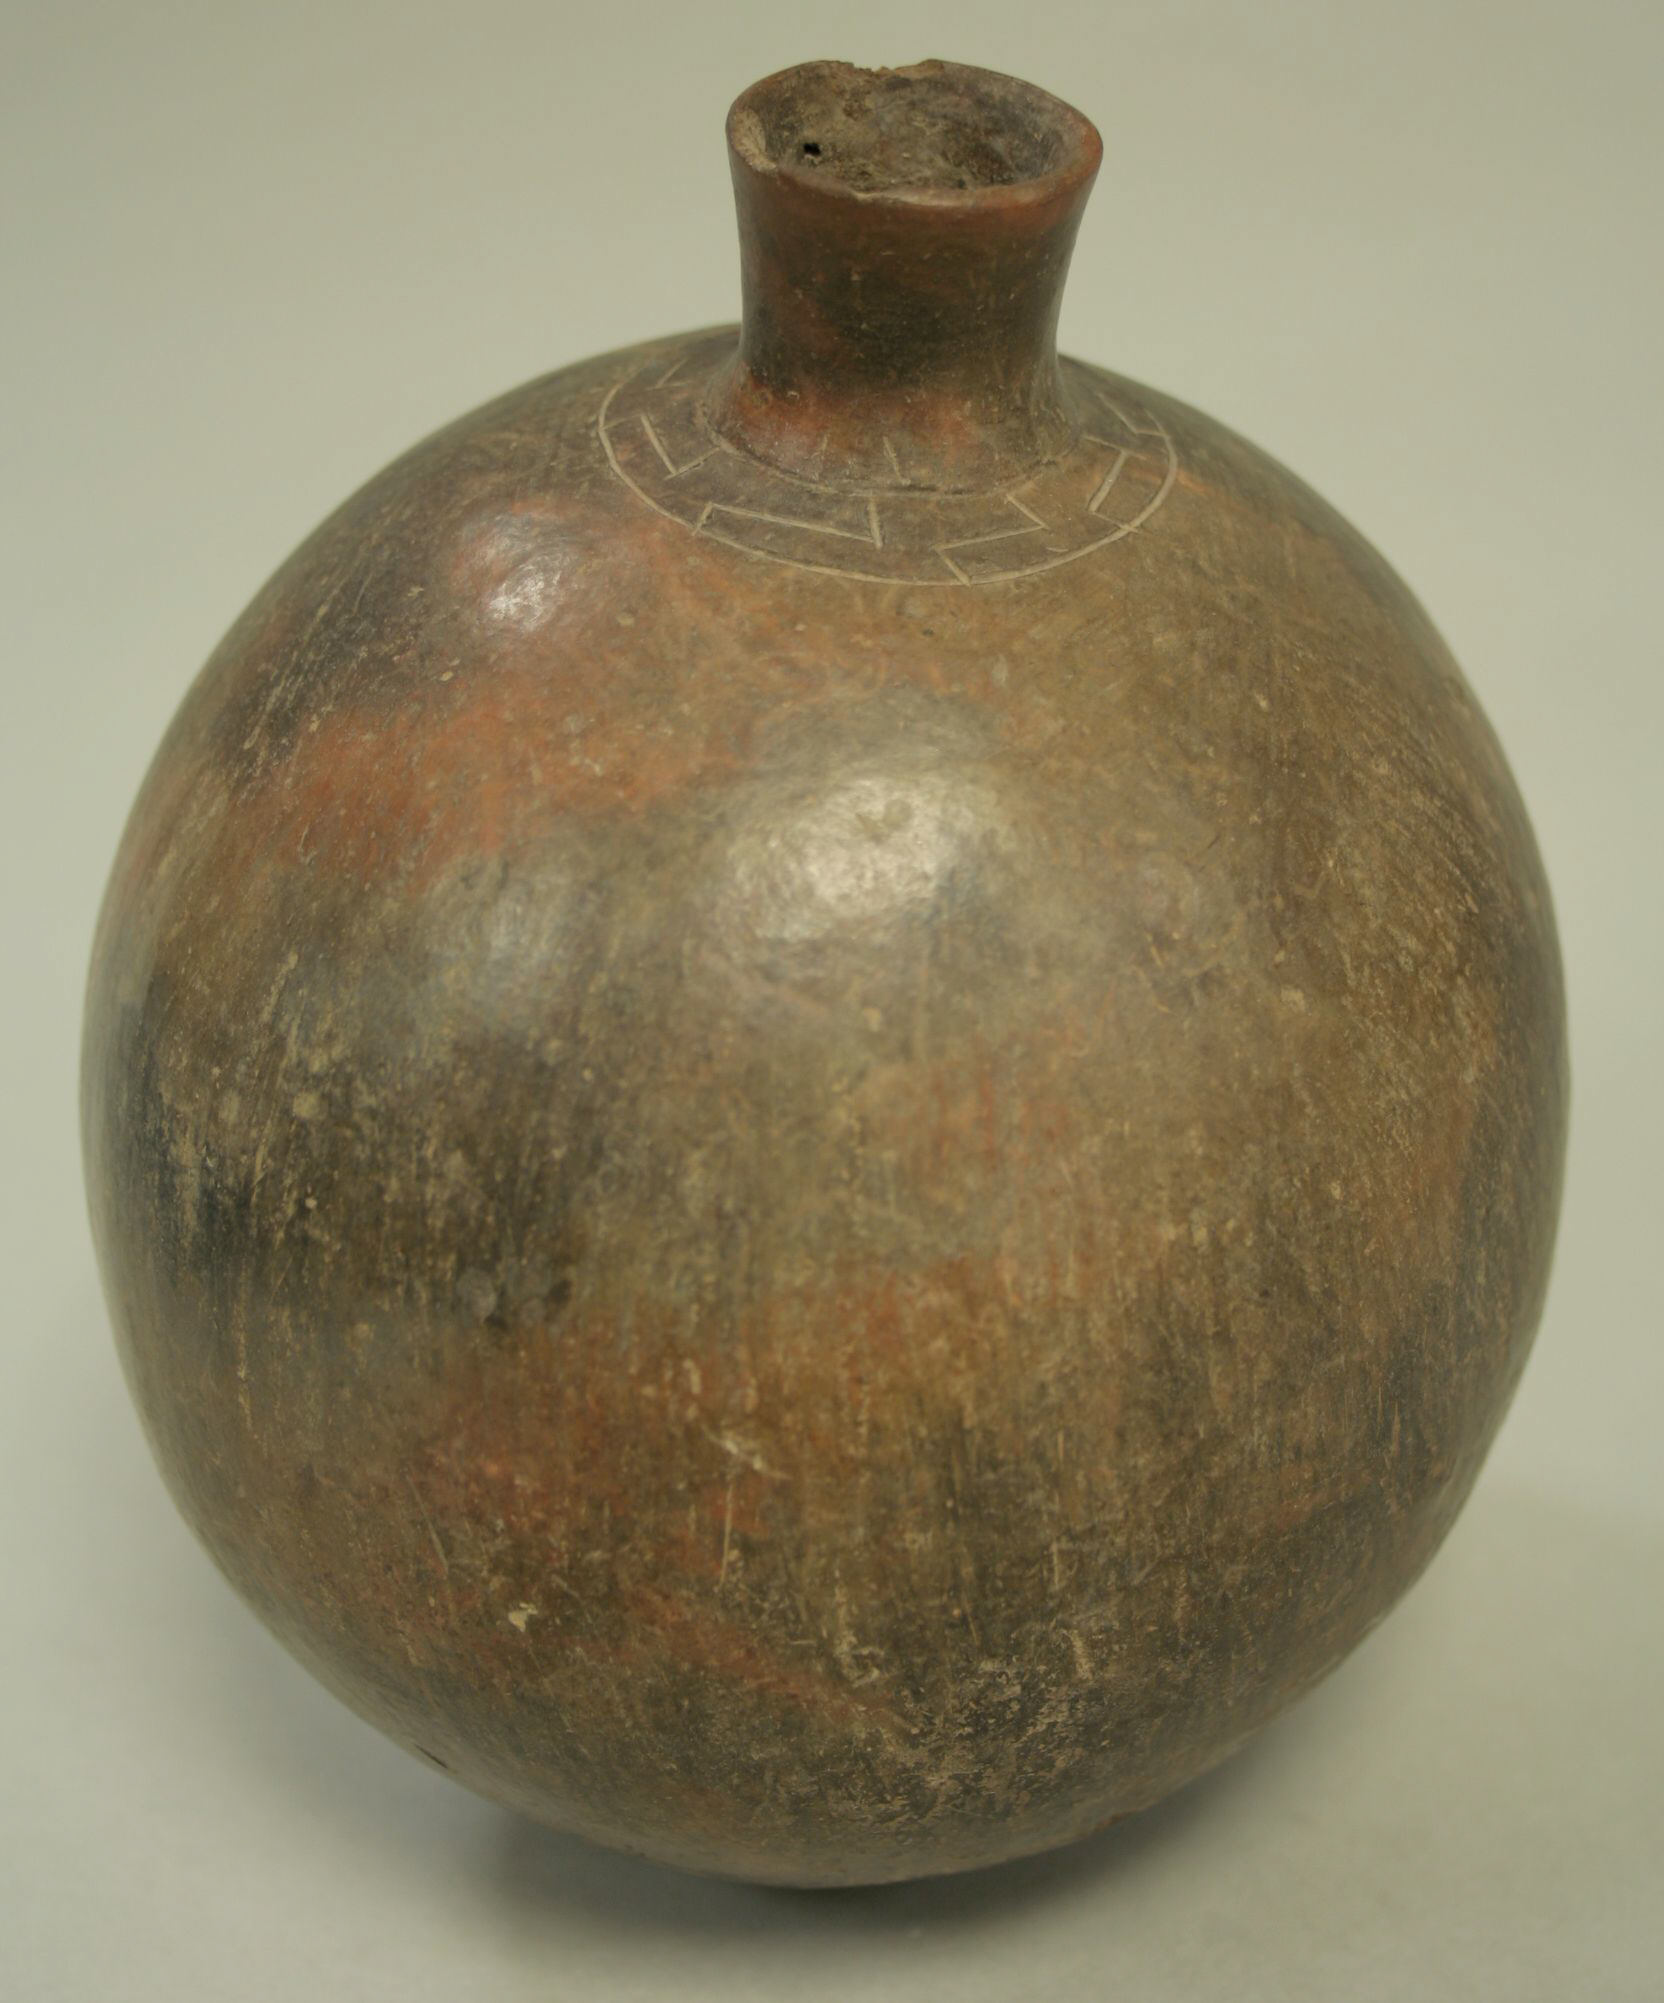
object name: bottle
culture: paracas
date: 600-301 BCE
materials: ceramic, pigment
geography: peru